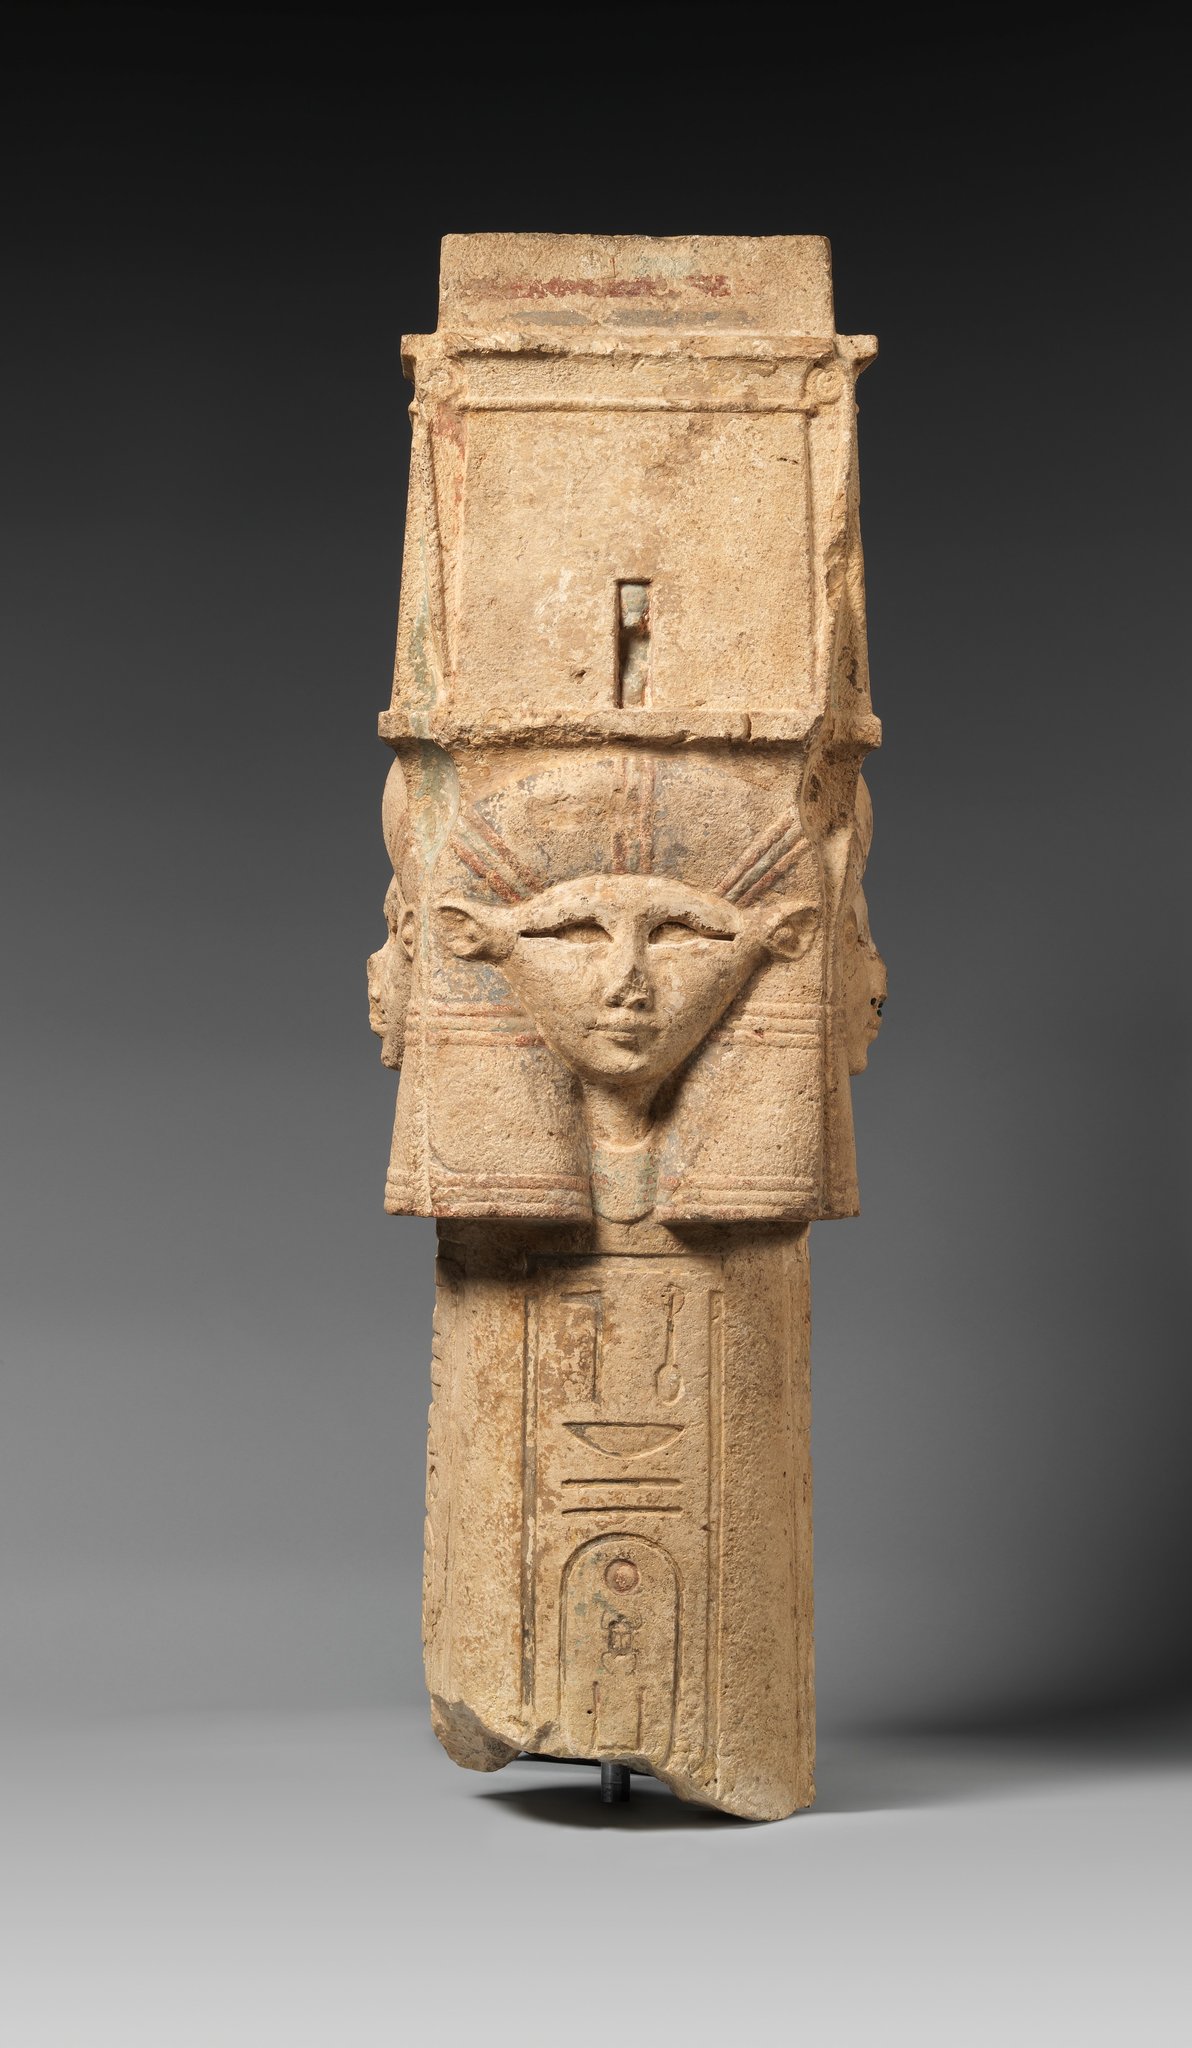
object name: column, hathor emblem capital, nectanebo i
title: Column with Hathor-emblem capital and names of Nectanebo I on the shaft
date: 380-362 BCE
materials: limestone, paint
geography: egypt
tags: hathor